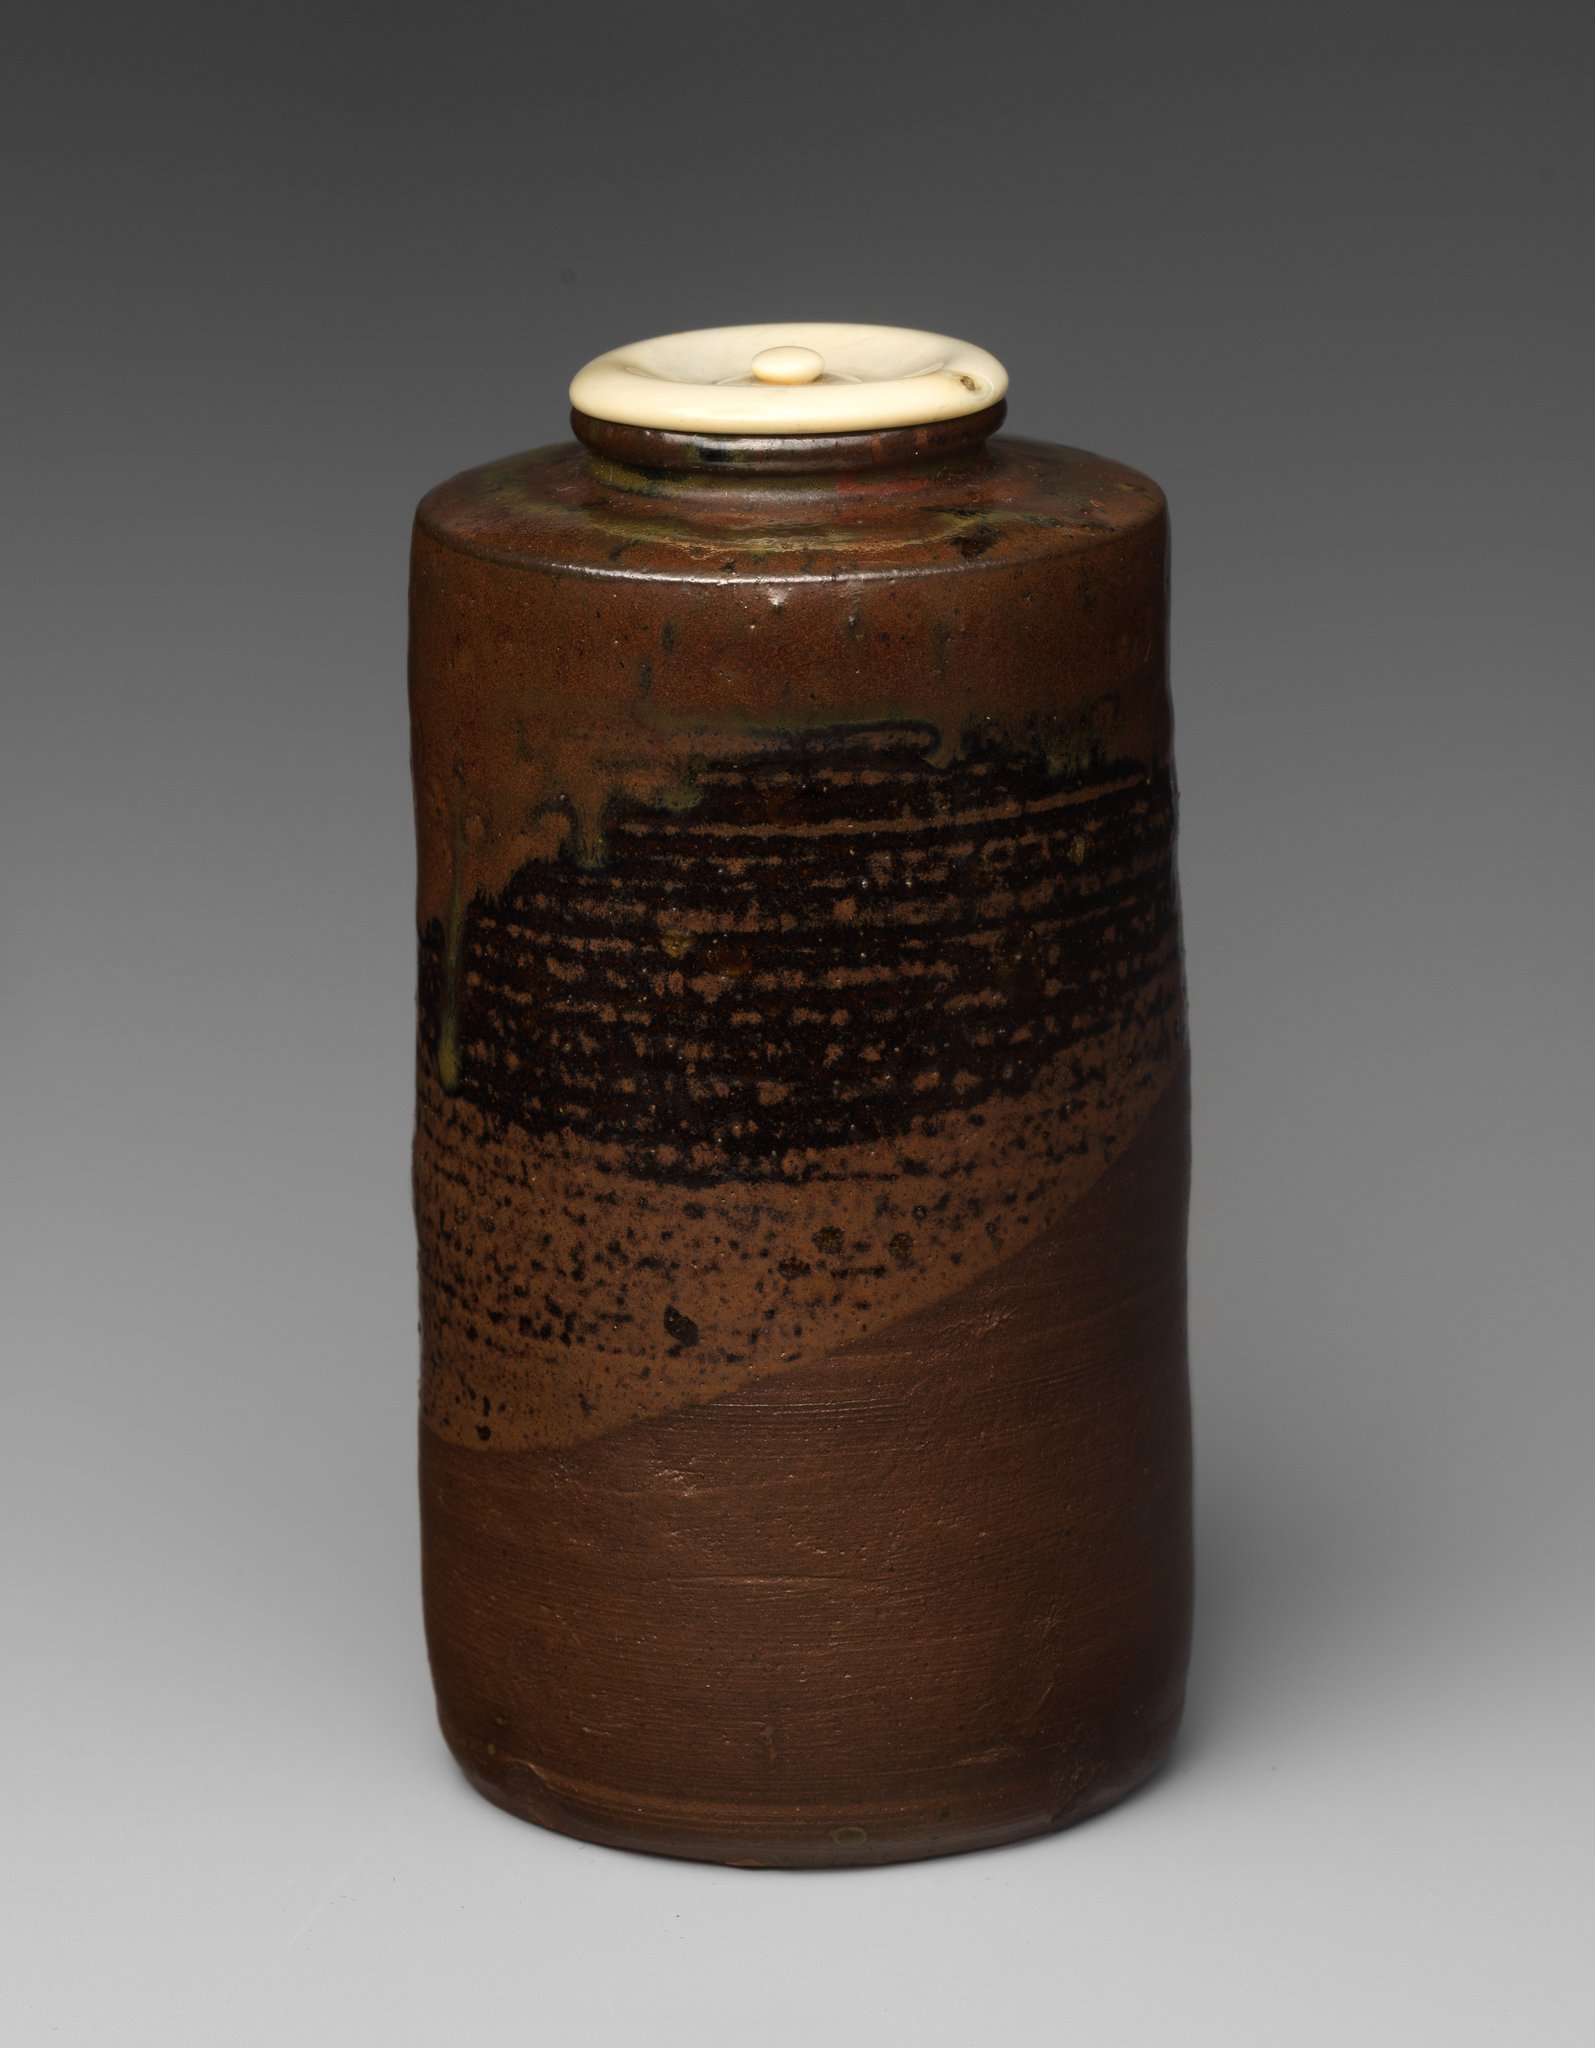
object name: tea jar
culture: japanese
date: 1701-1800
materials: glaze, paste